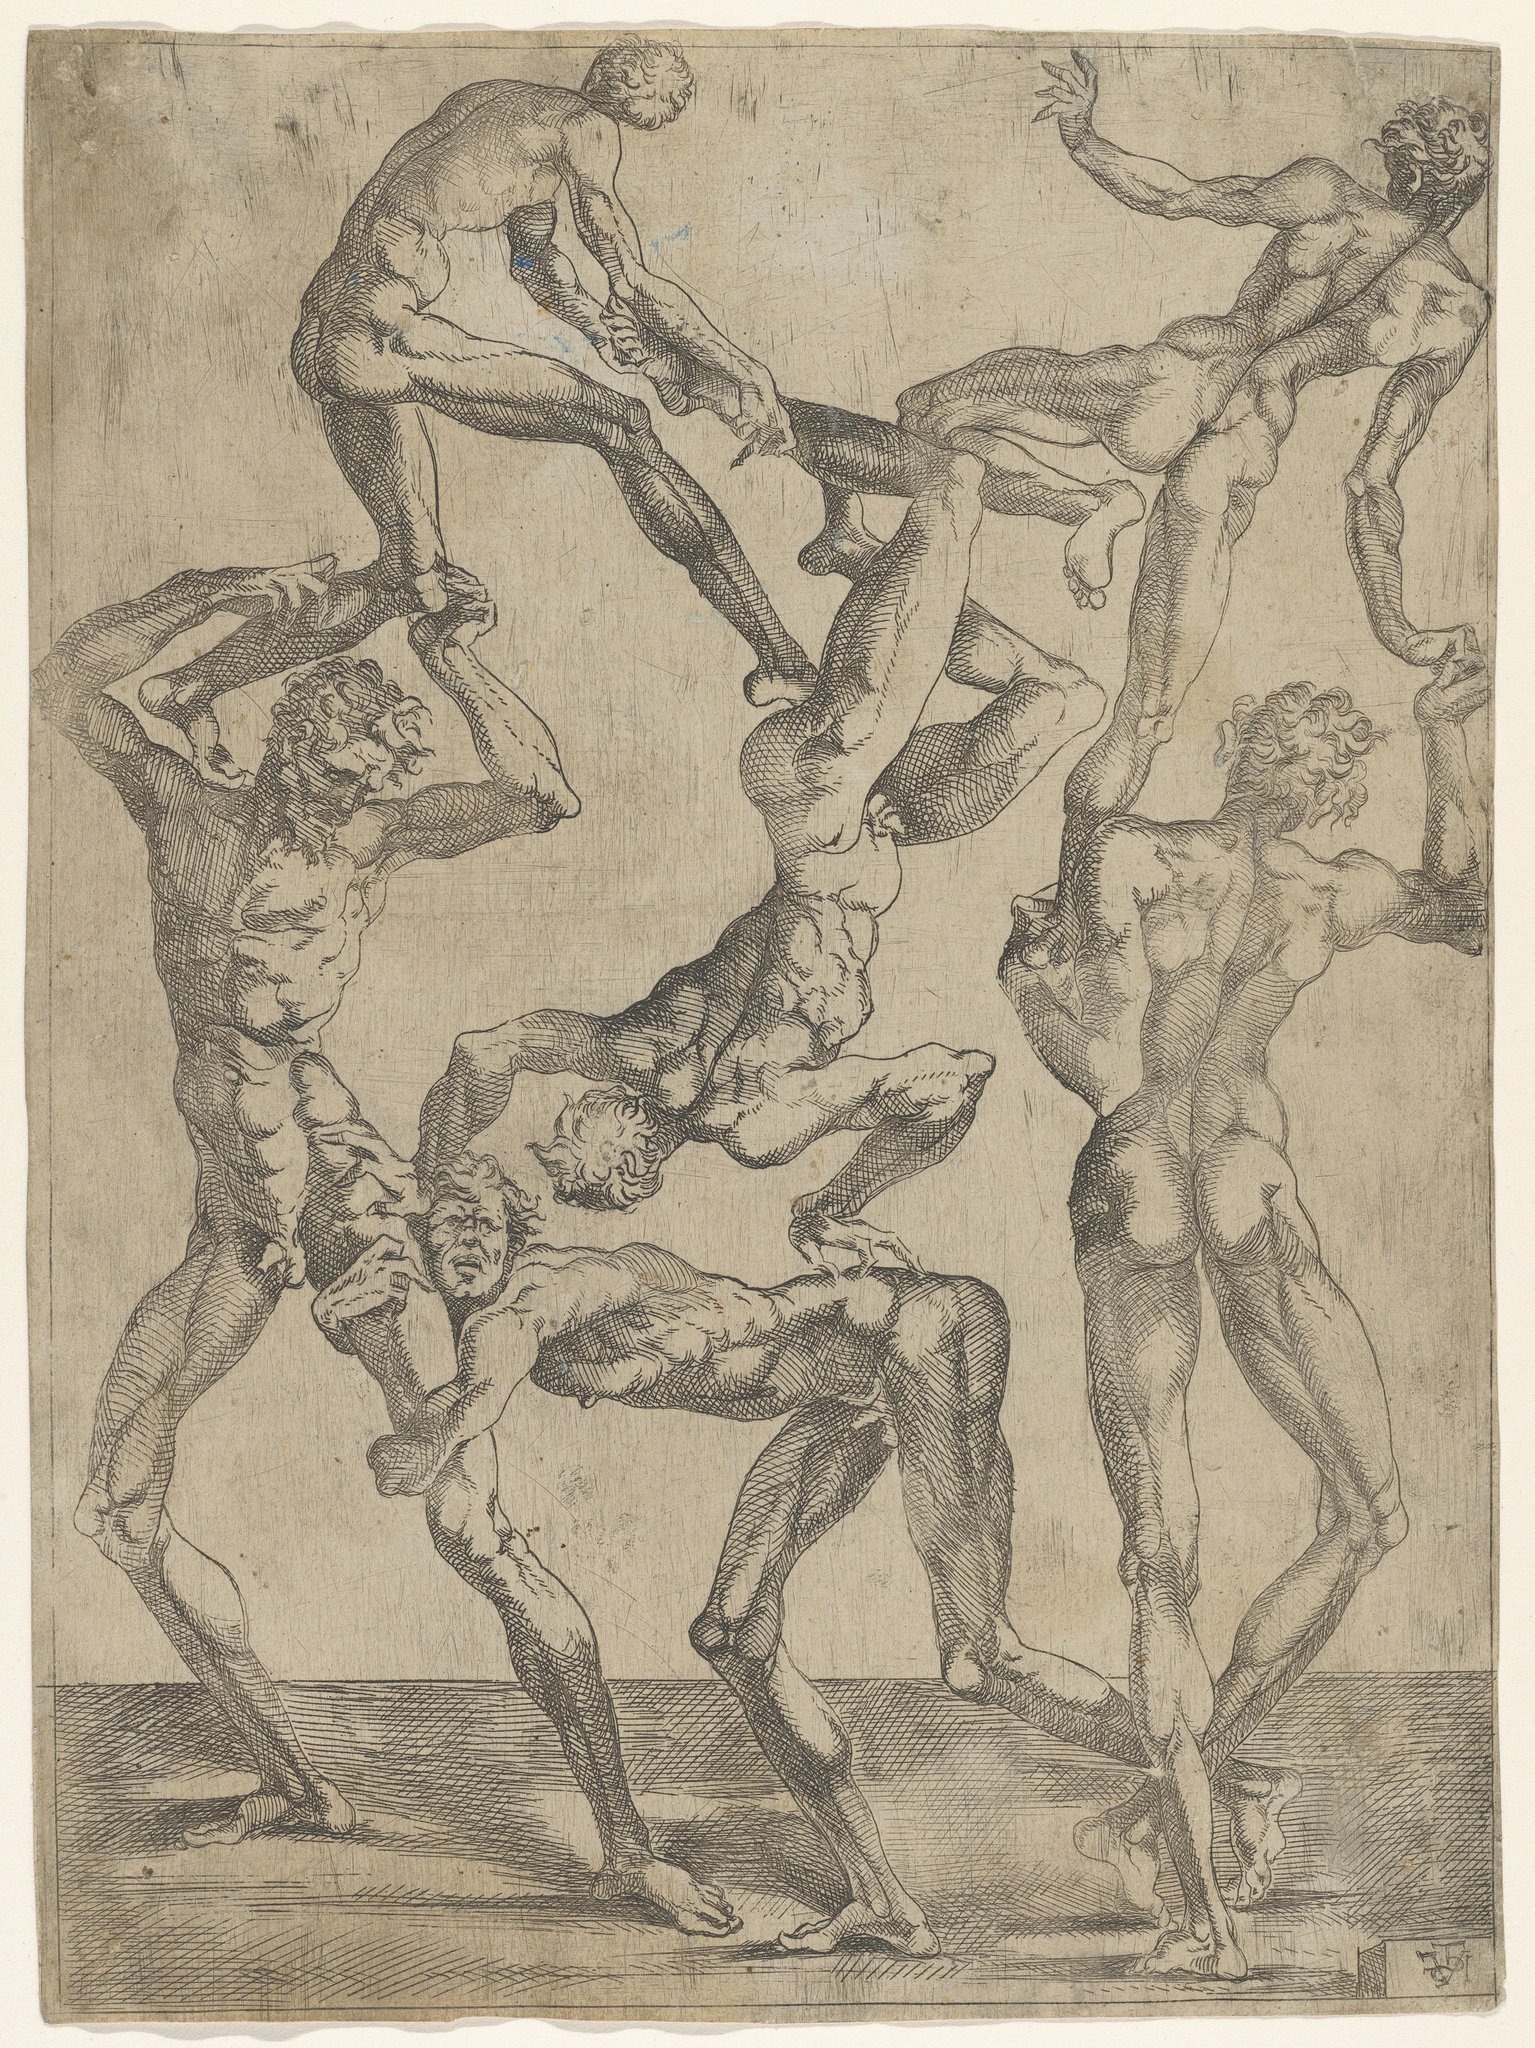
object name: print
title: Pyramid of Men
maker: juste de juste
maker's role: artist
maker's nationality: french, born italy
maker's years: 1505-1559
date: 1540-1550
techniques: etching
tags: male nudes